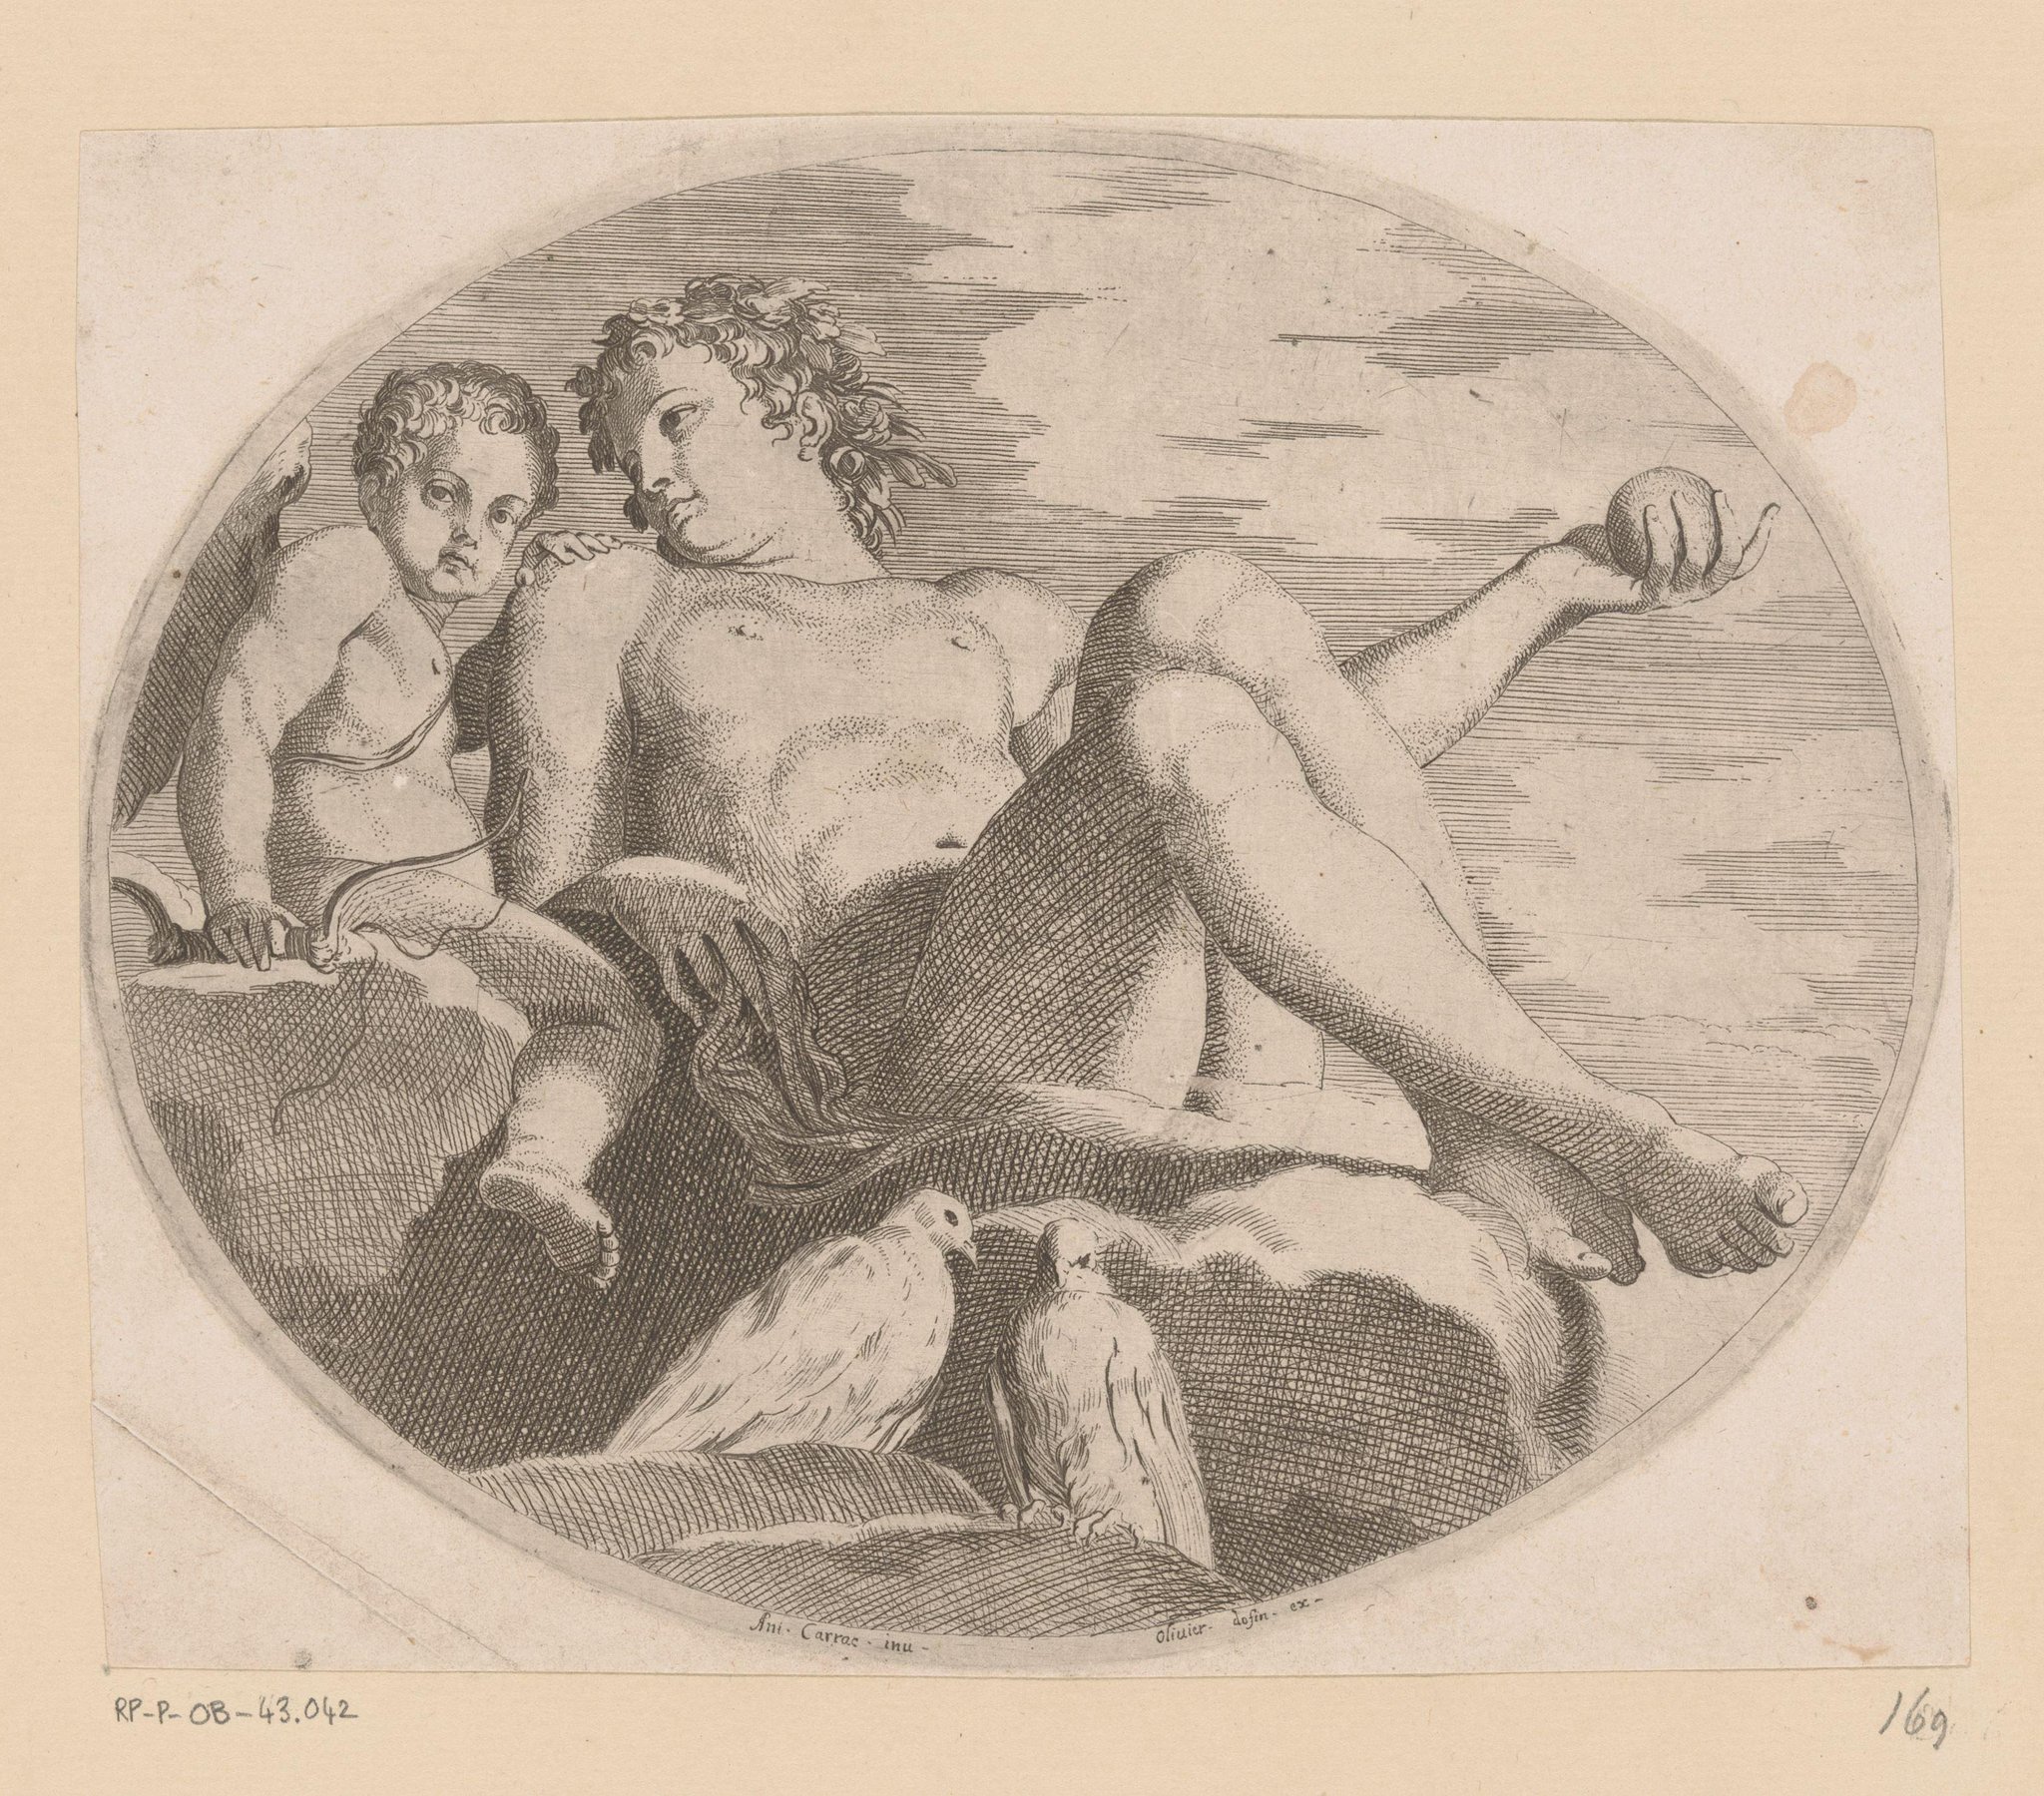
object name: print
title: Lucht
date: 1644-1683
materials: paper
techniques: etching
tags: air (one of the four elements), doves, pigeons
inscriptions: collector's mark: Lugt 240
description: Maakt deel uit van een vierdelige serie met personificaties van de vier elementen